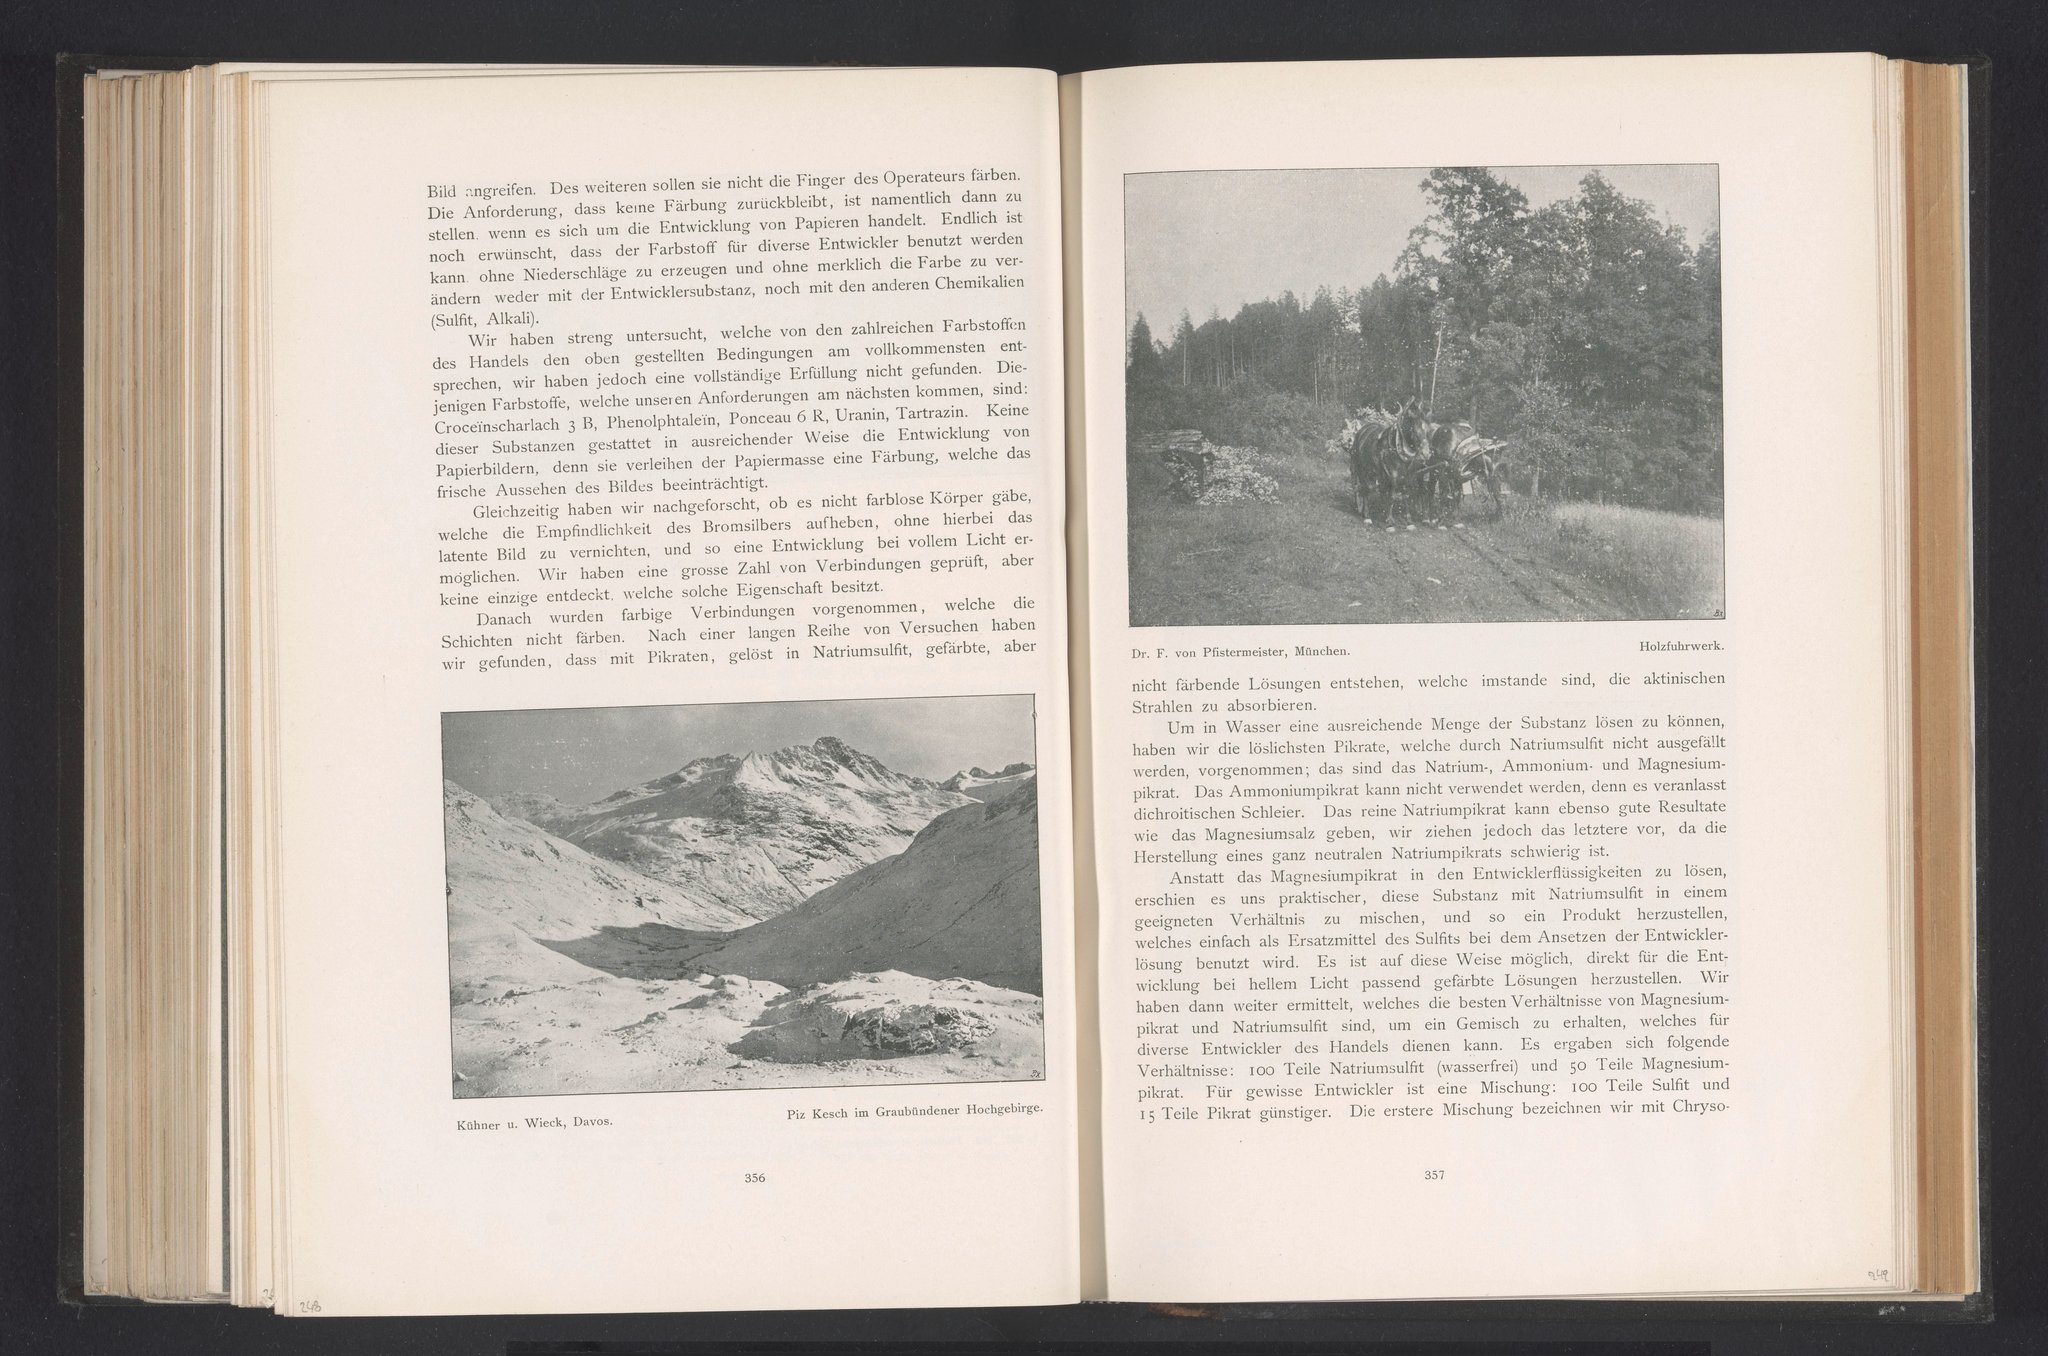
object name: photomechanical print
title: Piz Kesch im Graubündener Hochgebirge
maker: Anonymous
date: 1898-1903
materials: paper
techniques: autotype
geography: graubunden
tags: landscapes, mountain-range, snow peaks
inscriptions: monogram: ‘BX’